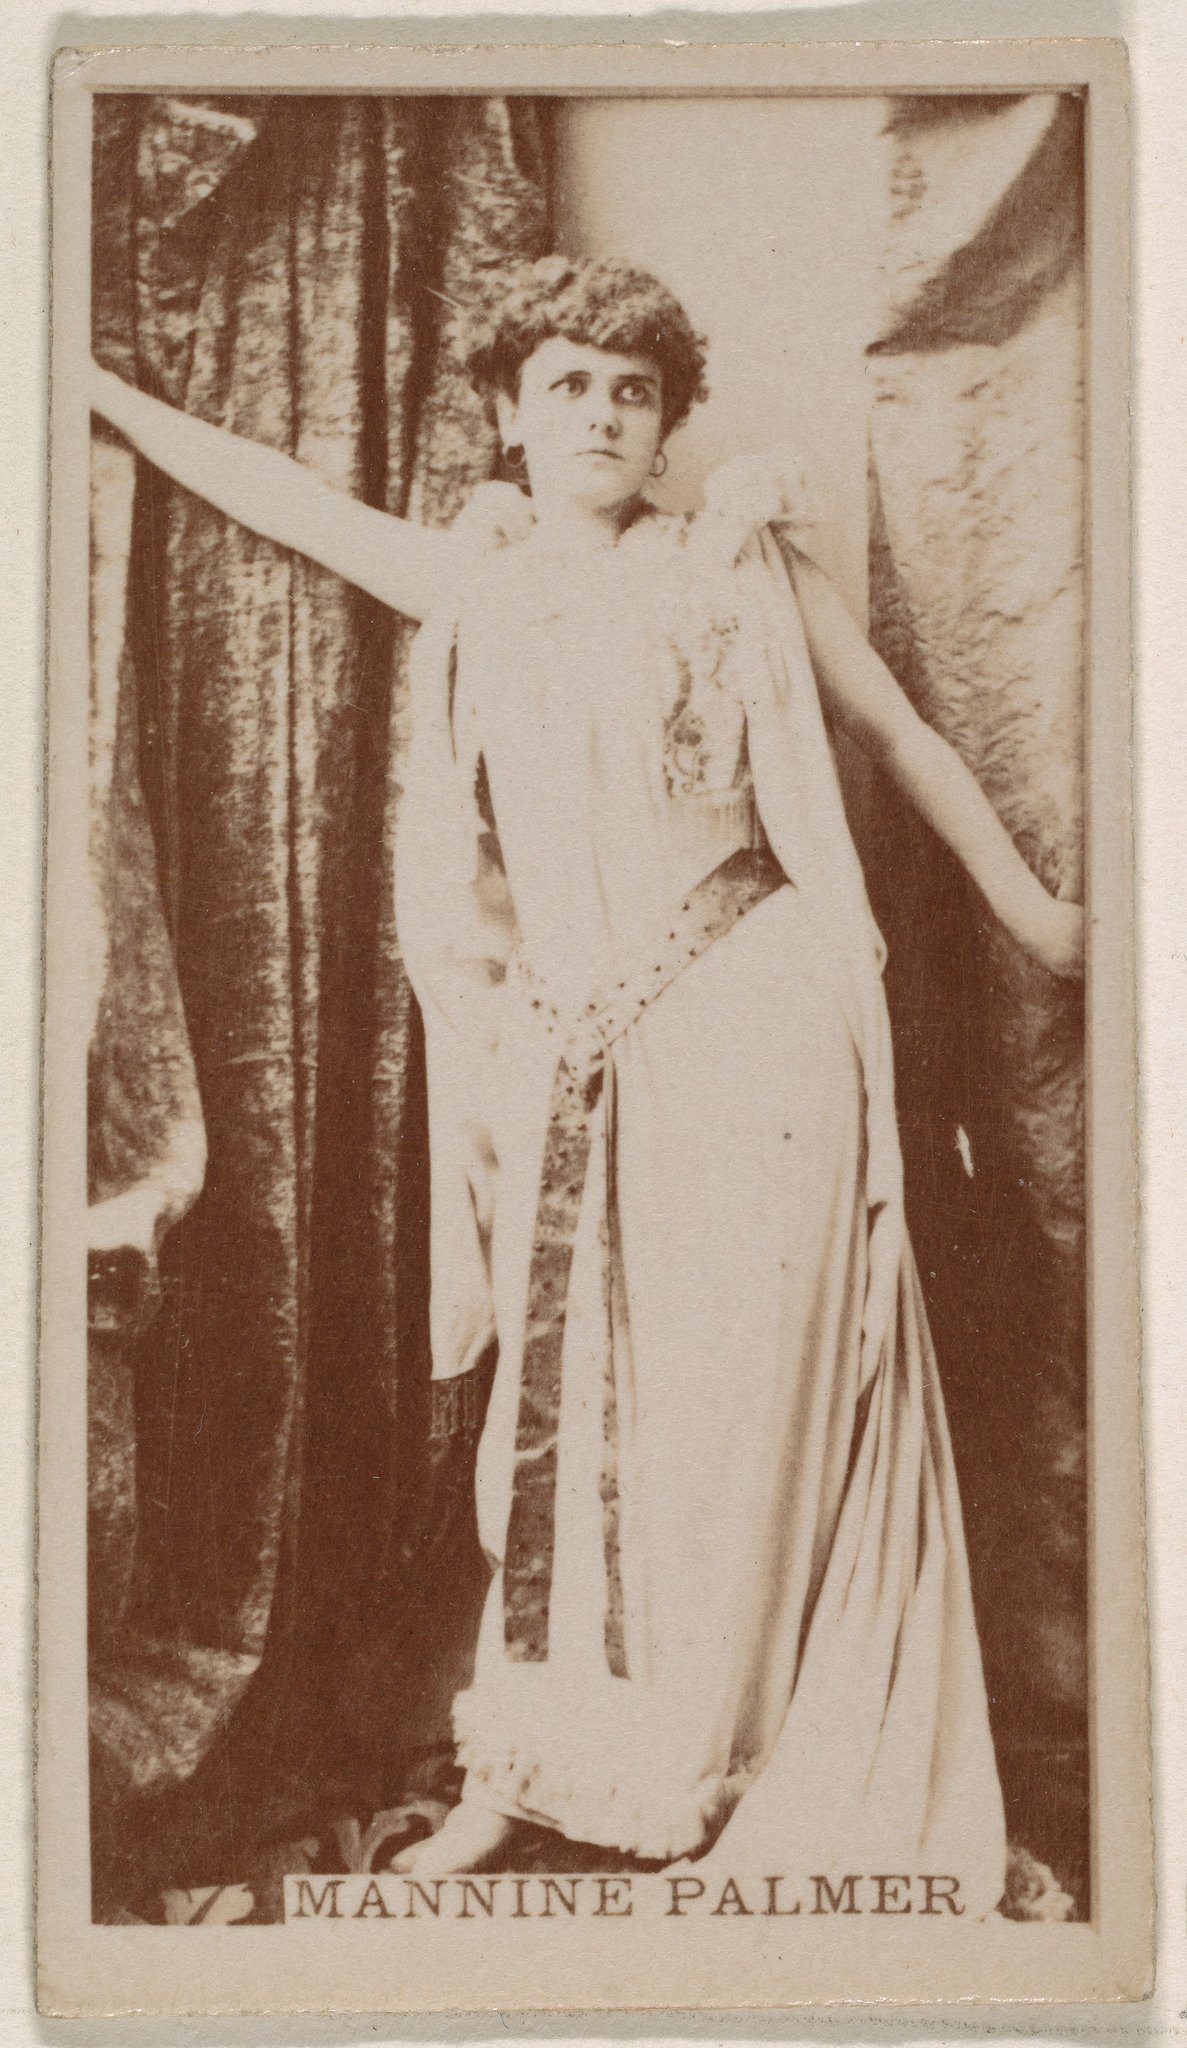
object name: photograph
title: Mannine Palmer, from the Actresses series (N245) issued by Kinney Brothers to promote Sweet Caporal Cigarettes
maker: kinney brothers tobacco company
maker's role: publisher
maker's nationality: american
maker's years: 1869-2011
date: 1890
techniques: albumen silver print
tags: portraits,women,actresses